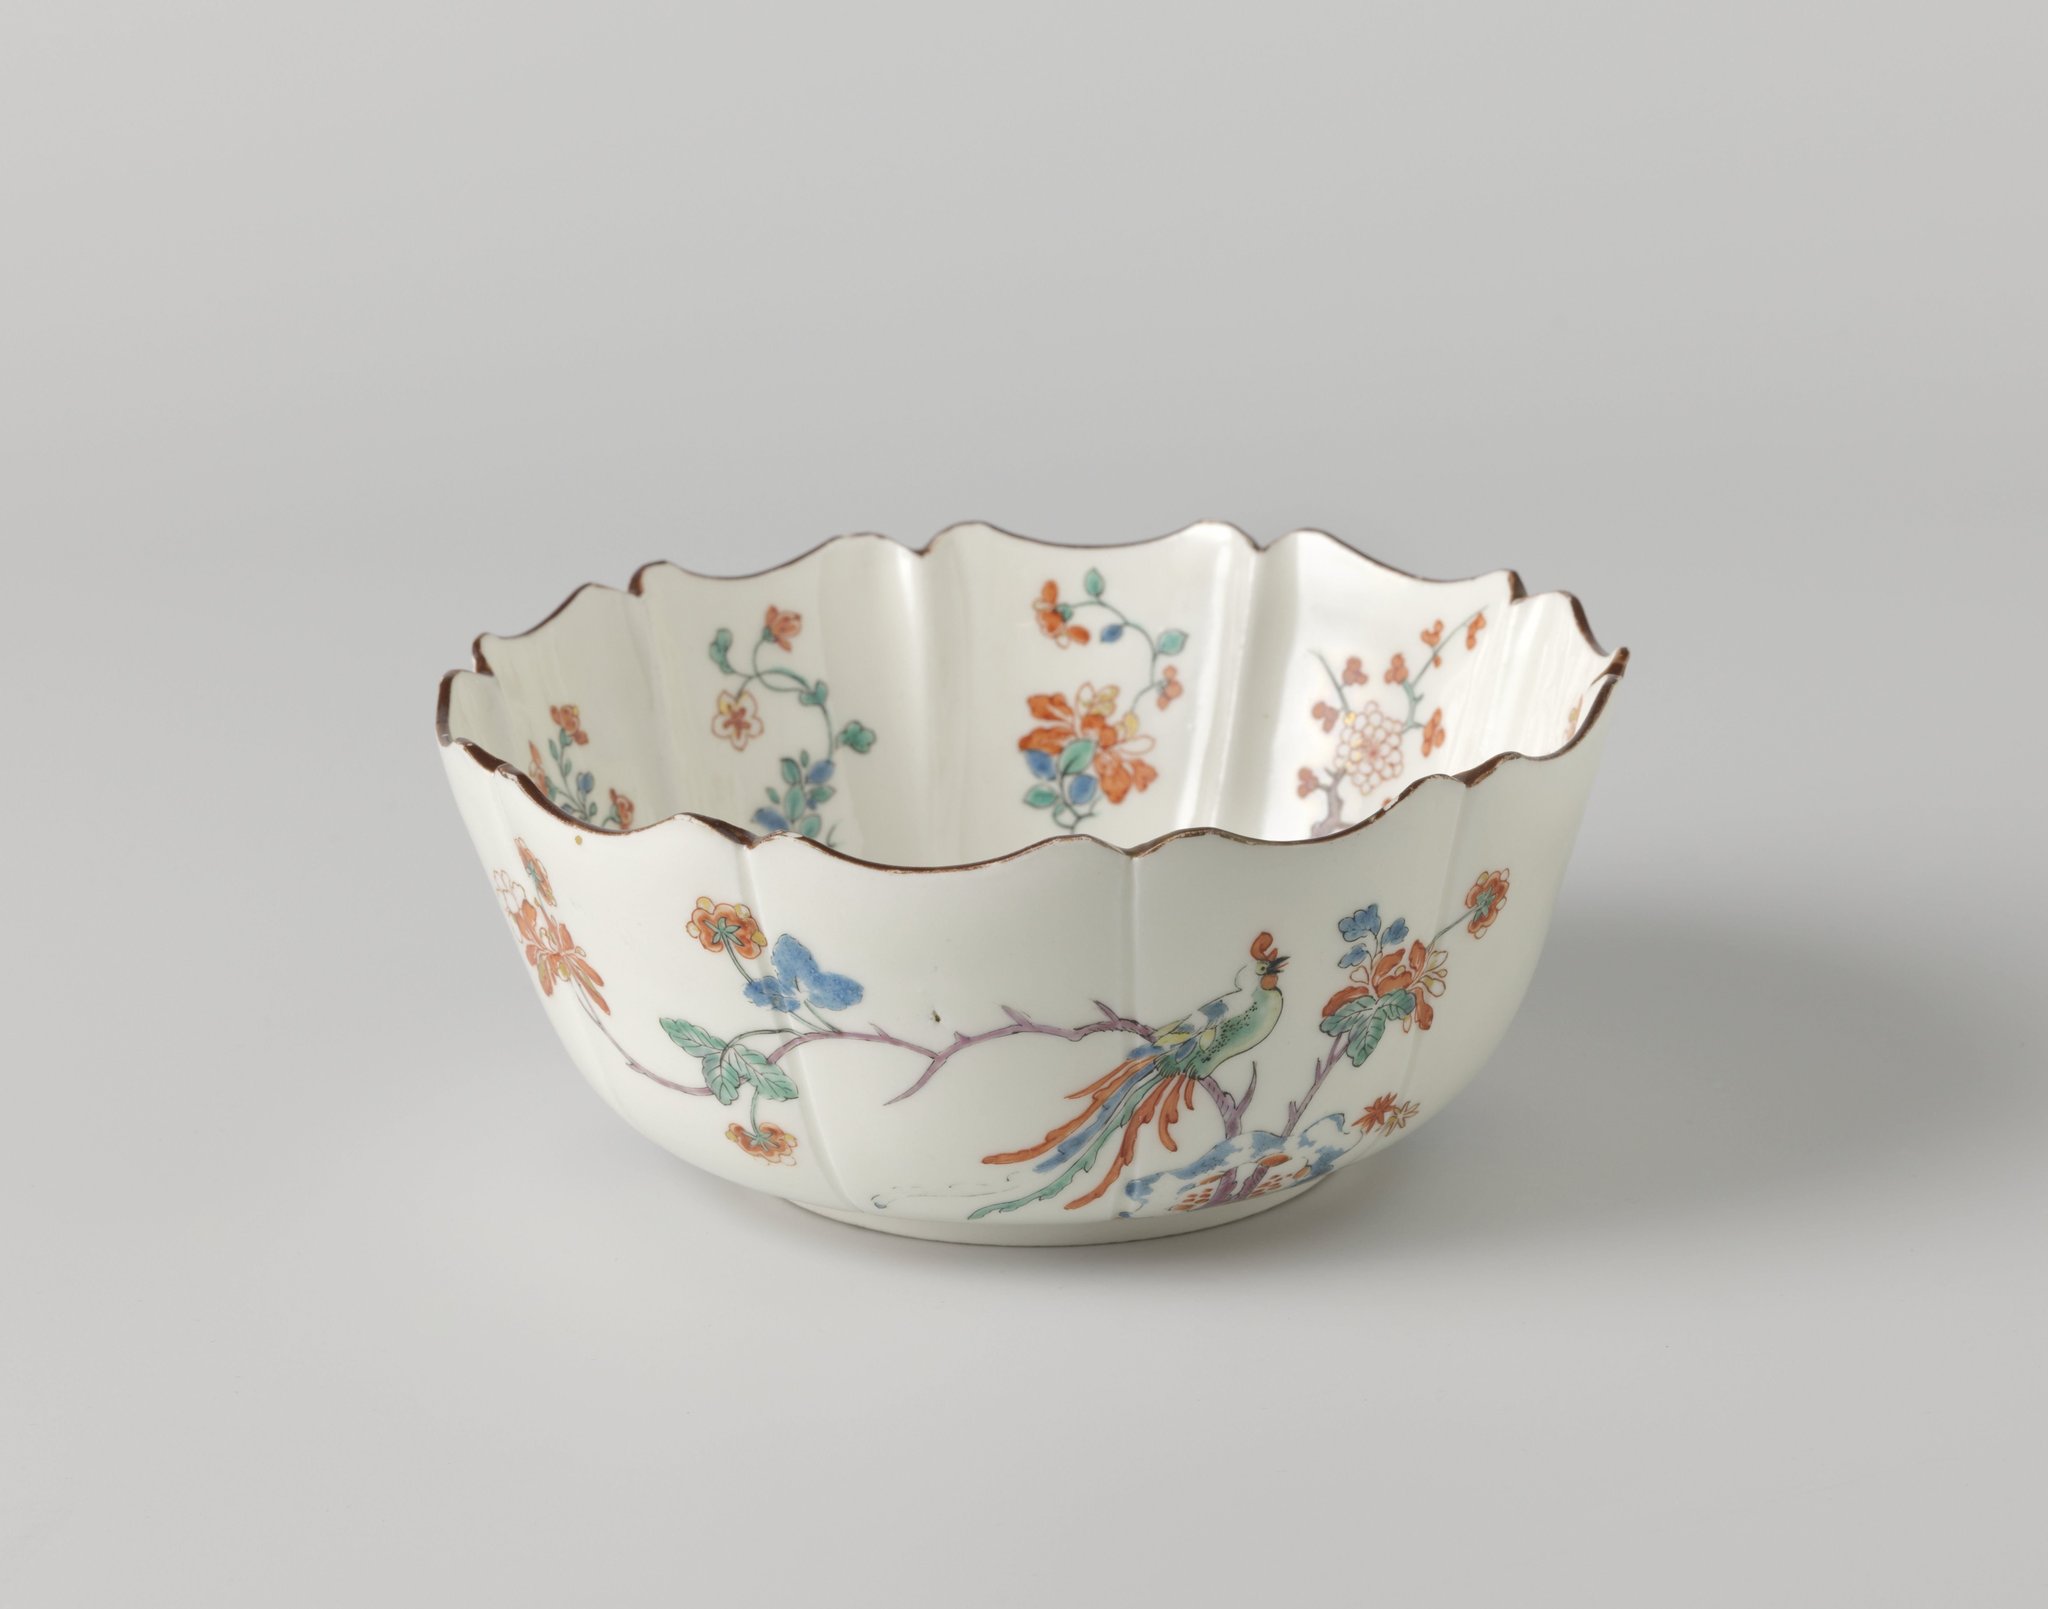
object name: bowl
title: Kom van veelkleurig beschilderd porselein.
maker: Anonymous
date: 1720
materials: porcelain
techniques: painted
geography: netherlands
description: Bowl. Meissen (?), c. 1715 - 1725, c. decorated 1715 - 1725.